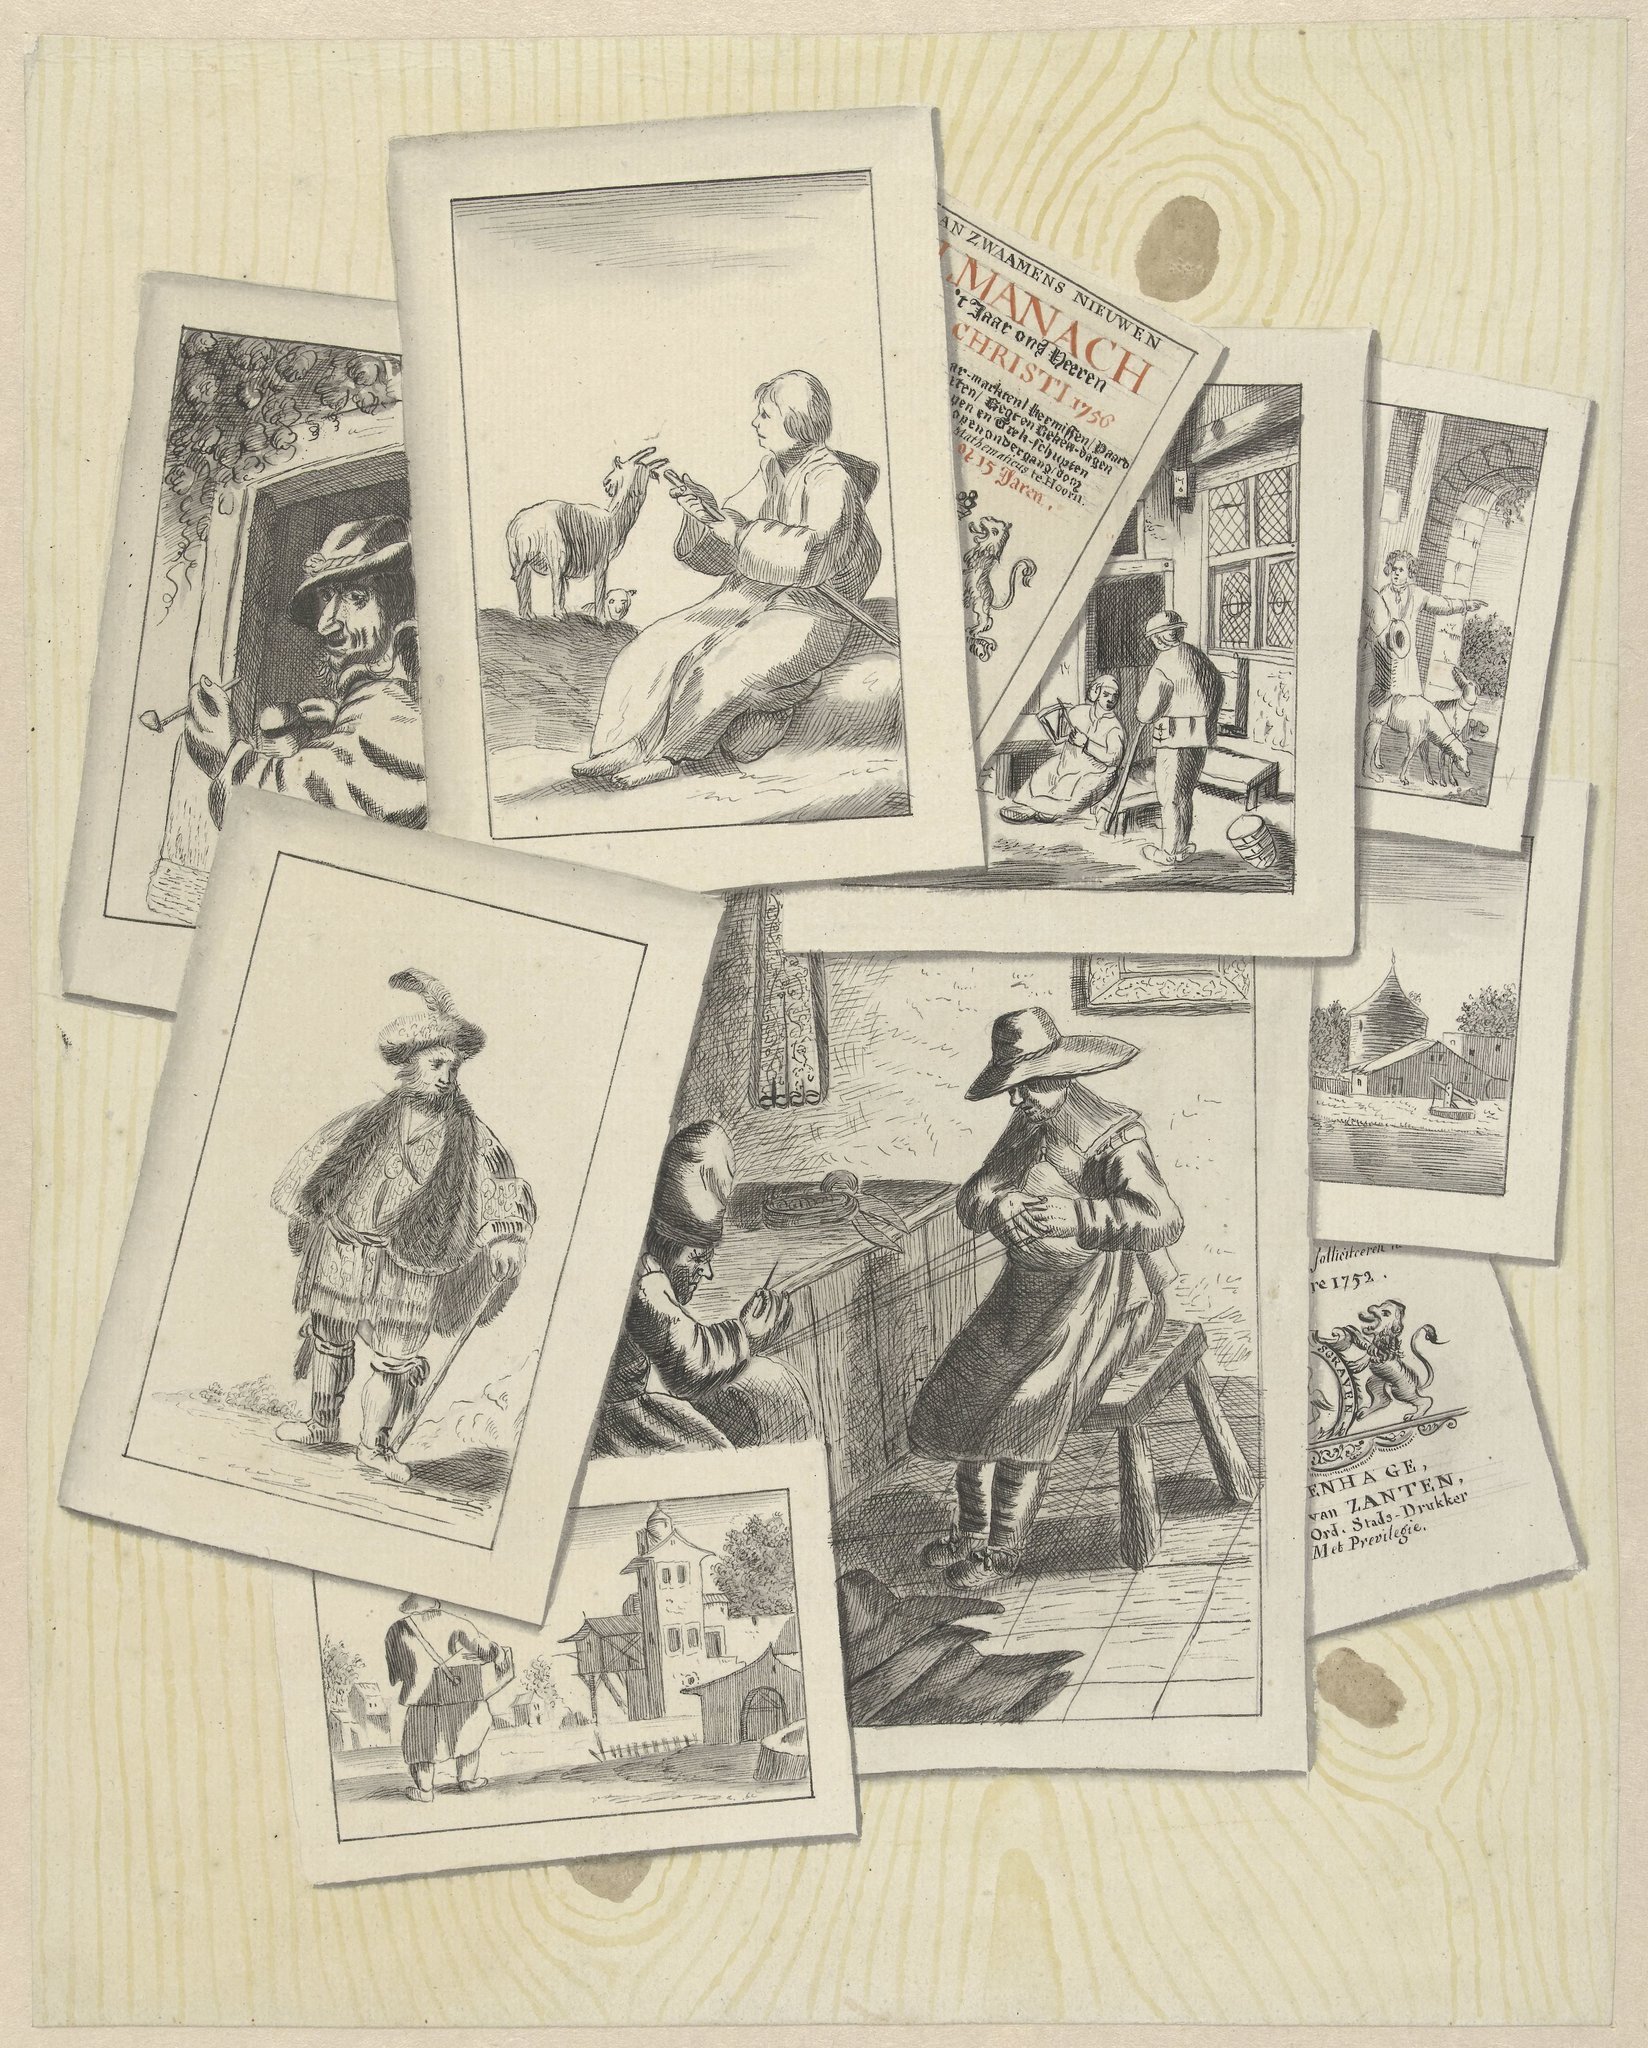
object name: drawing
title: Bedriegertje met veel prenten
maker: Anonymous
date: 1700-1800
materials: ink, paper, pencil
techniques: brush, pen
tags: 'trompe l'oeil', maps of separate countries or regions, print, e.g.: engraving, etching, lithograph